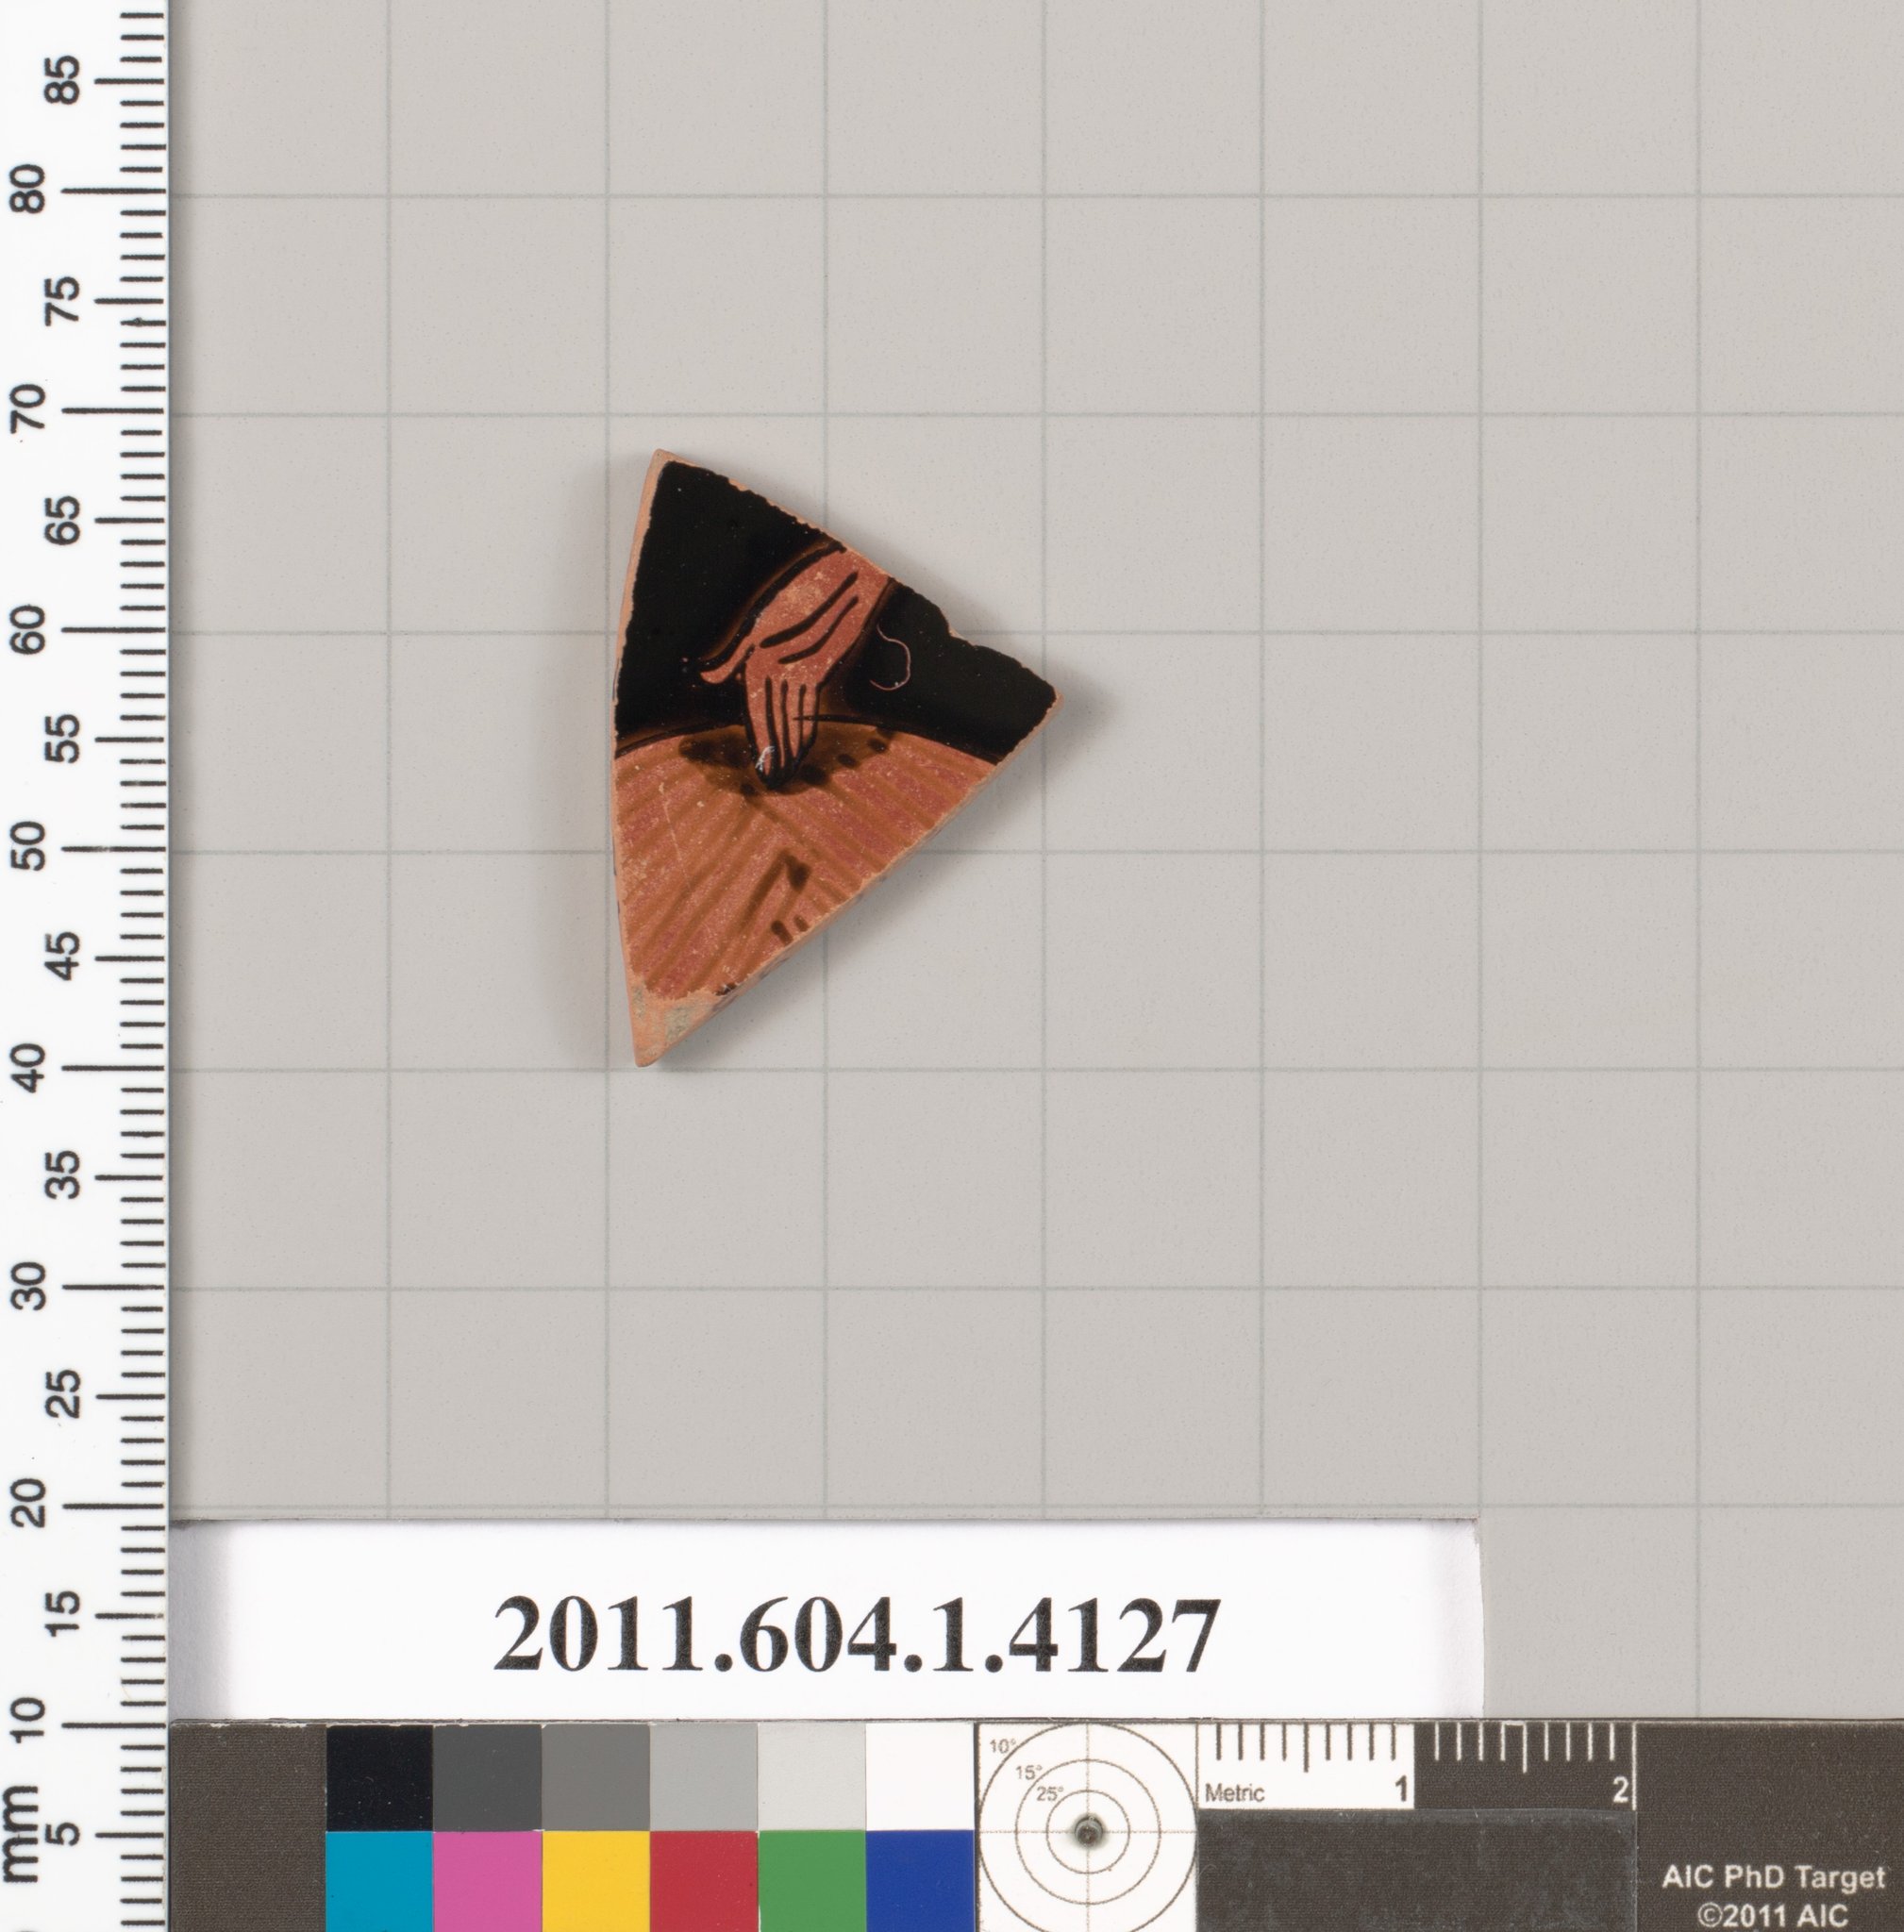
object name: kylix fragment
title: Terracotta fragment of a kylix (drinking cup)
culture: greek, attic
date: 490-470 BCE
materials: terracotta